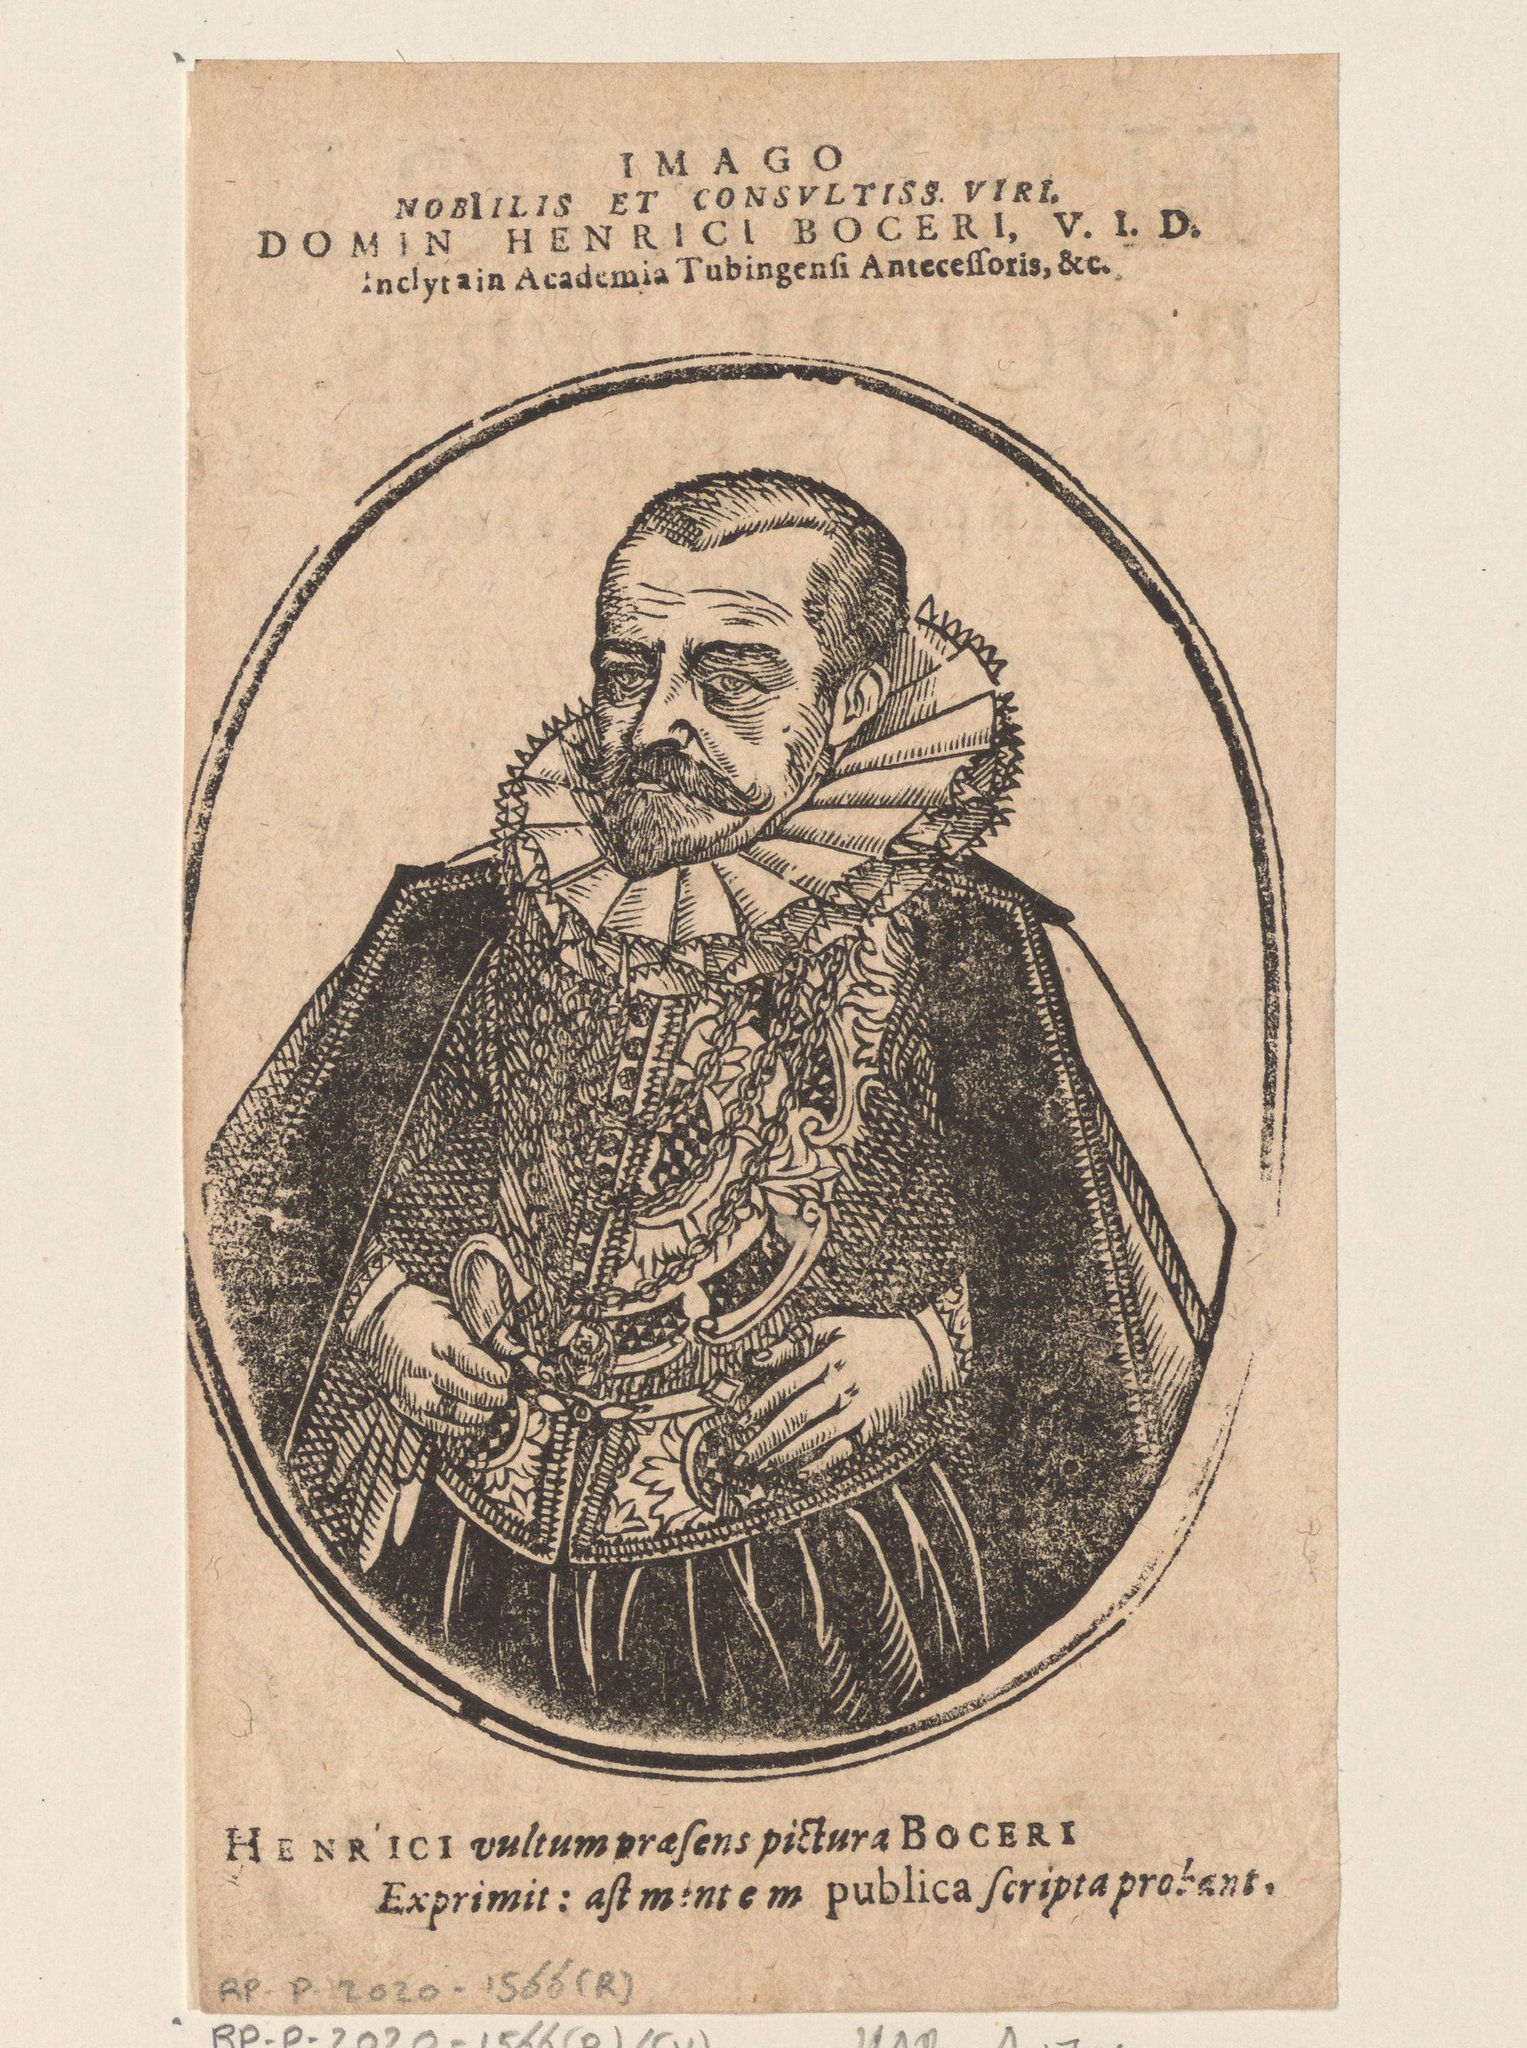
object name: book illustration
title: Portret van Heinrich Bocer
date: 1611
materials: paper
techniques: letterpress printing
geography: tübingen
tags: historical persons, portrait of a writer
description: Prent uit: Bocer, Heinrich. Tractatus feudales duo (...). Tübingen: Johann Alexander Cellius, 1611.